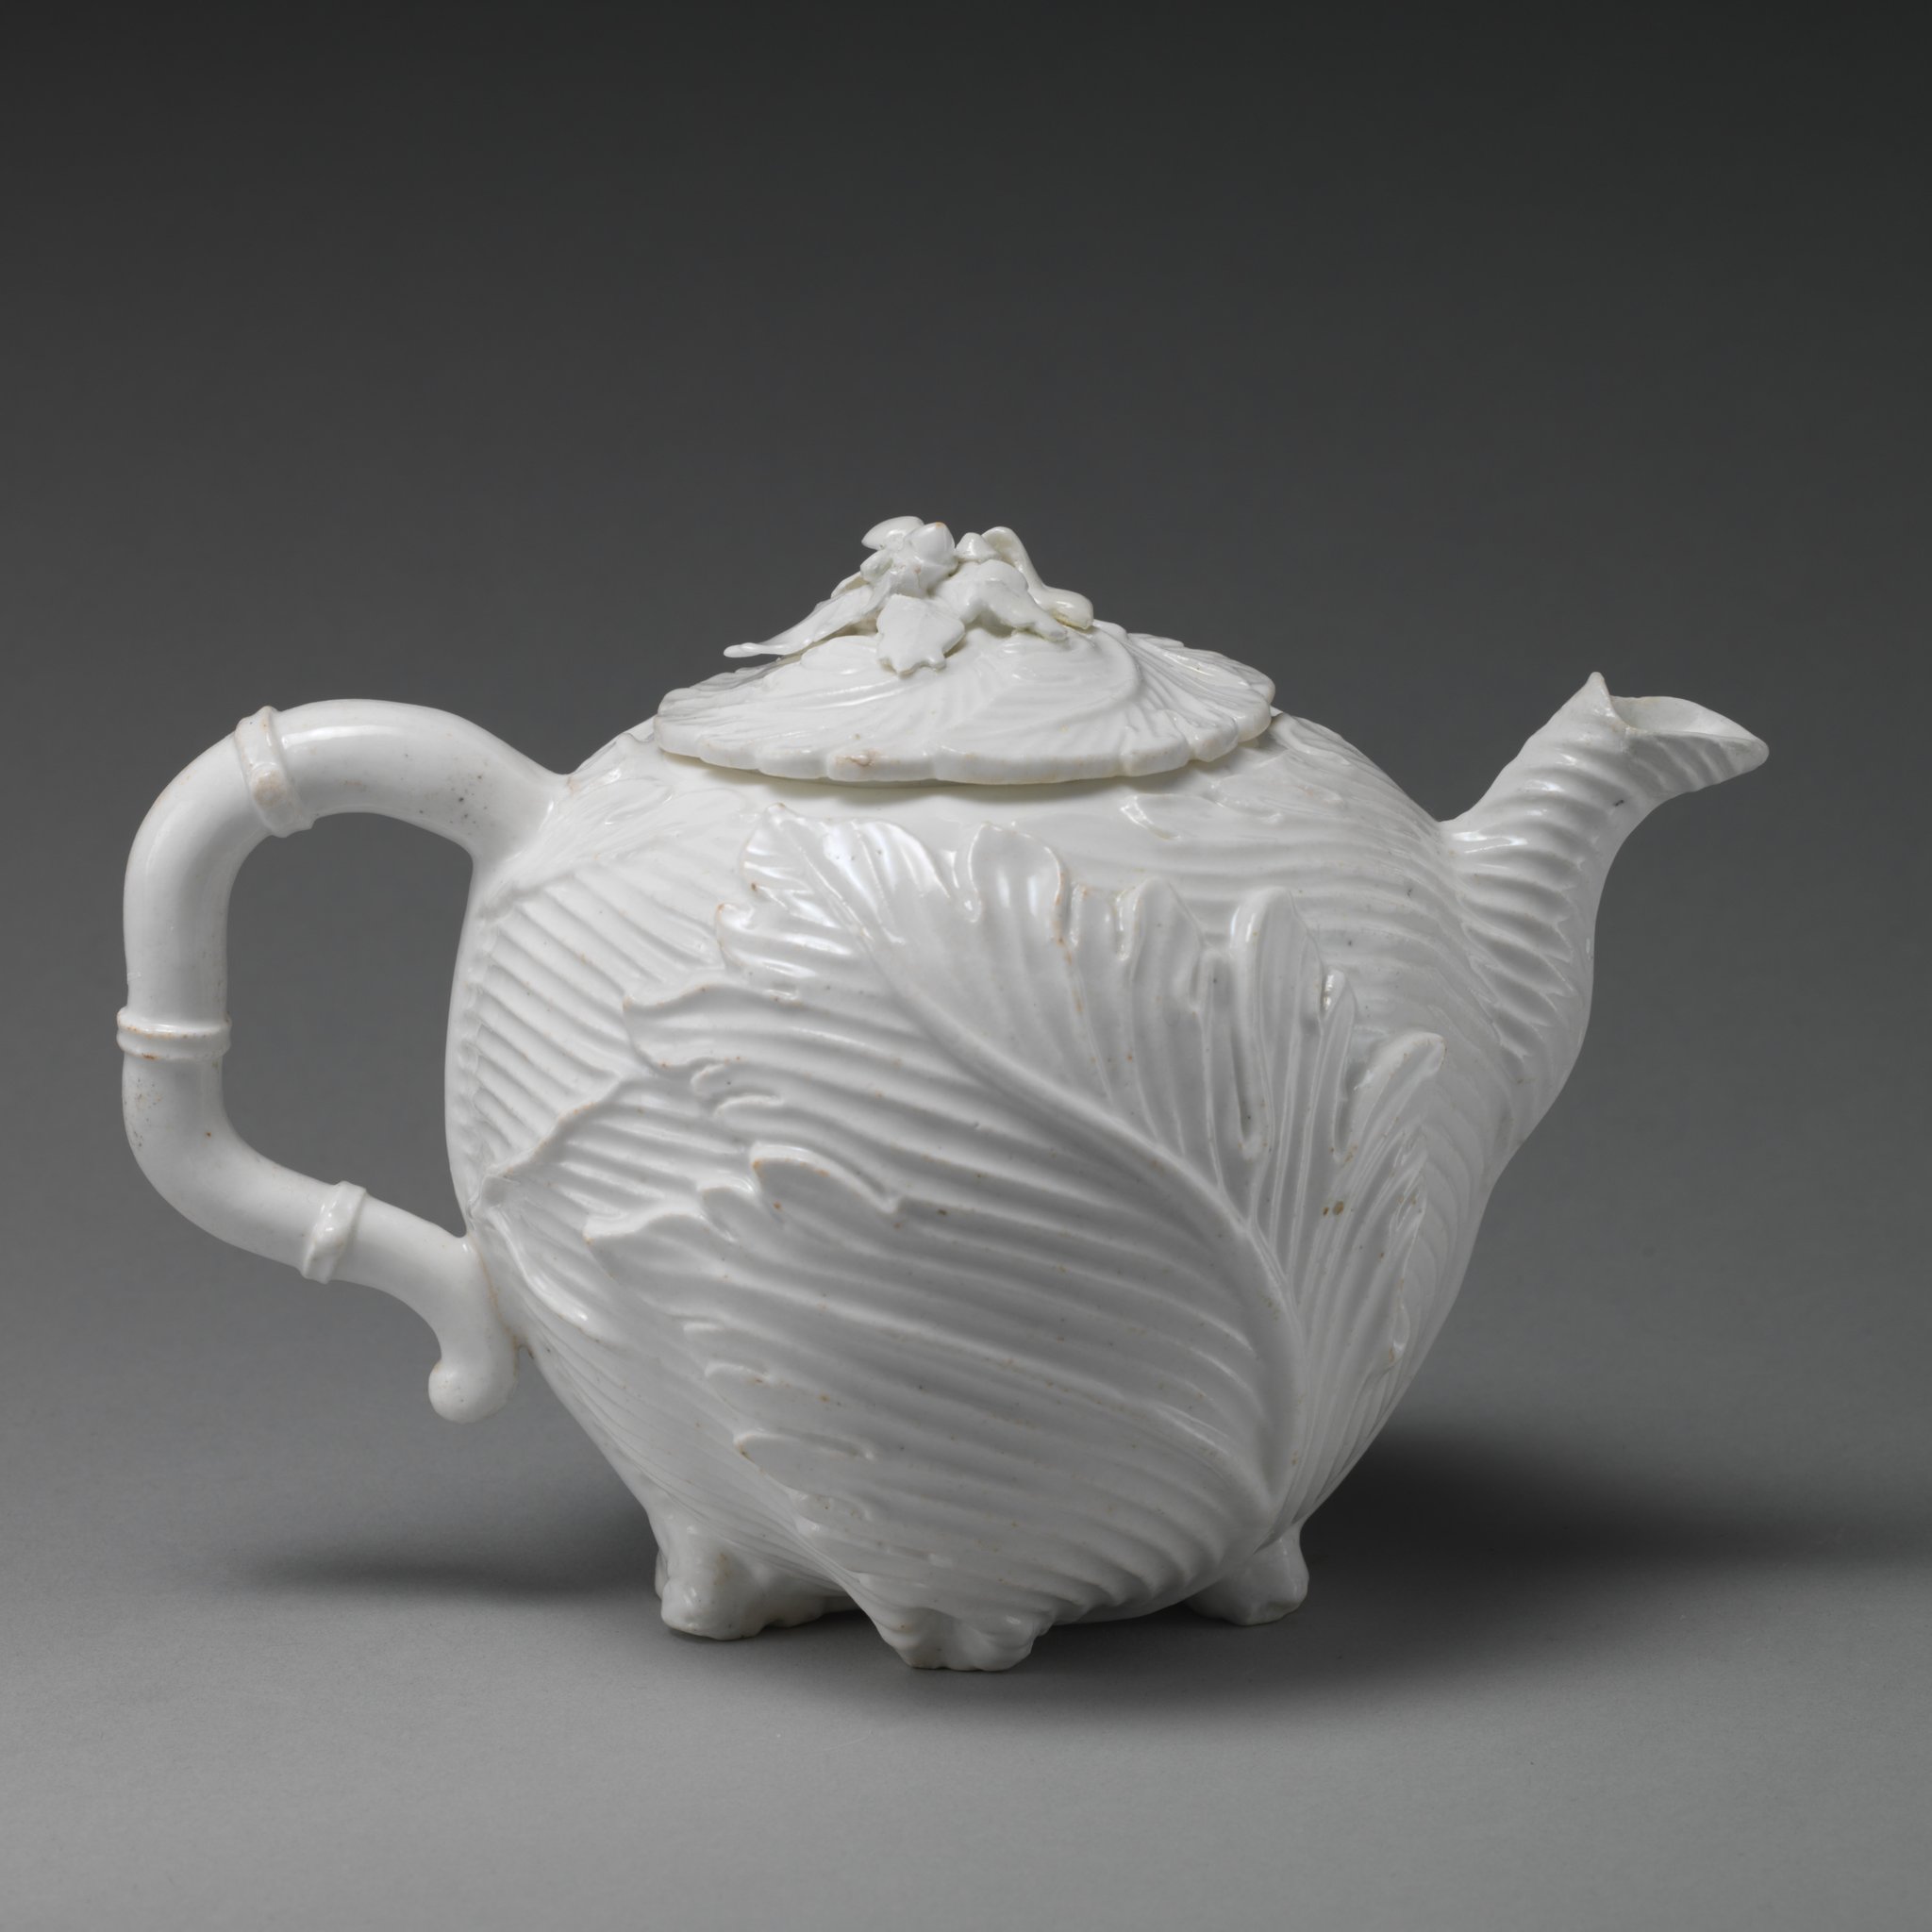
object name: teapot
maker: chelsea porcelain manufactory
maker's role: factory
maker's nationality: british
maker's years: 1744-1784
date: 1745-1749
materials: soft paste porcelain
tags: acanthus